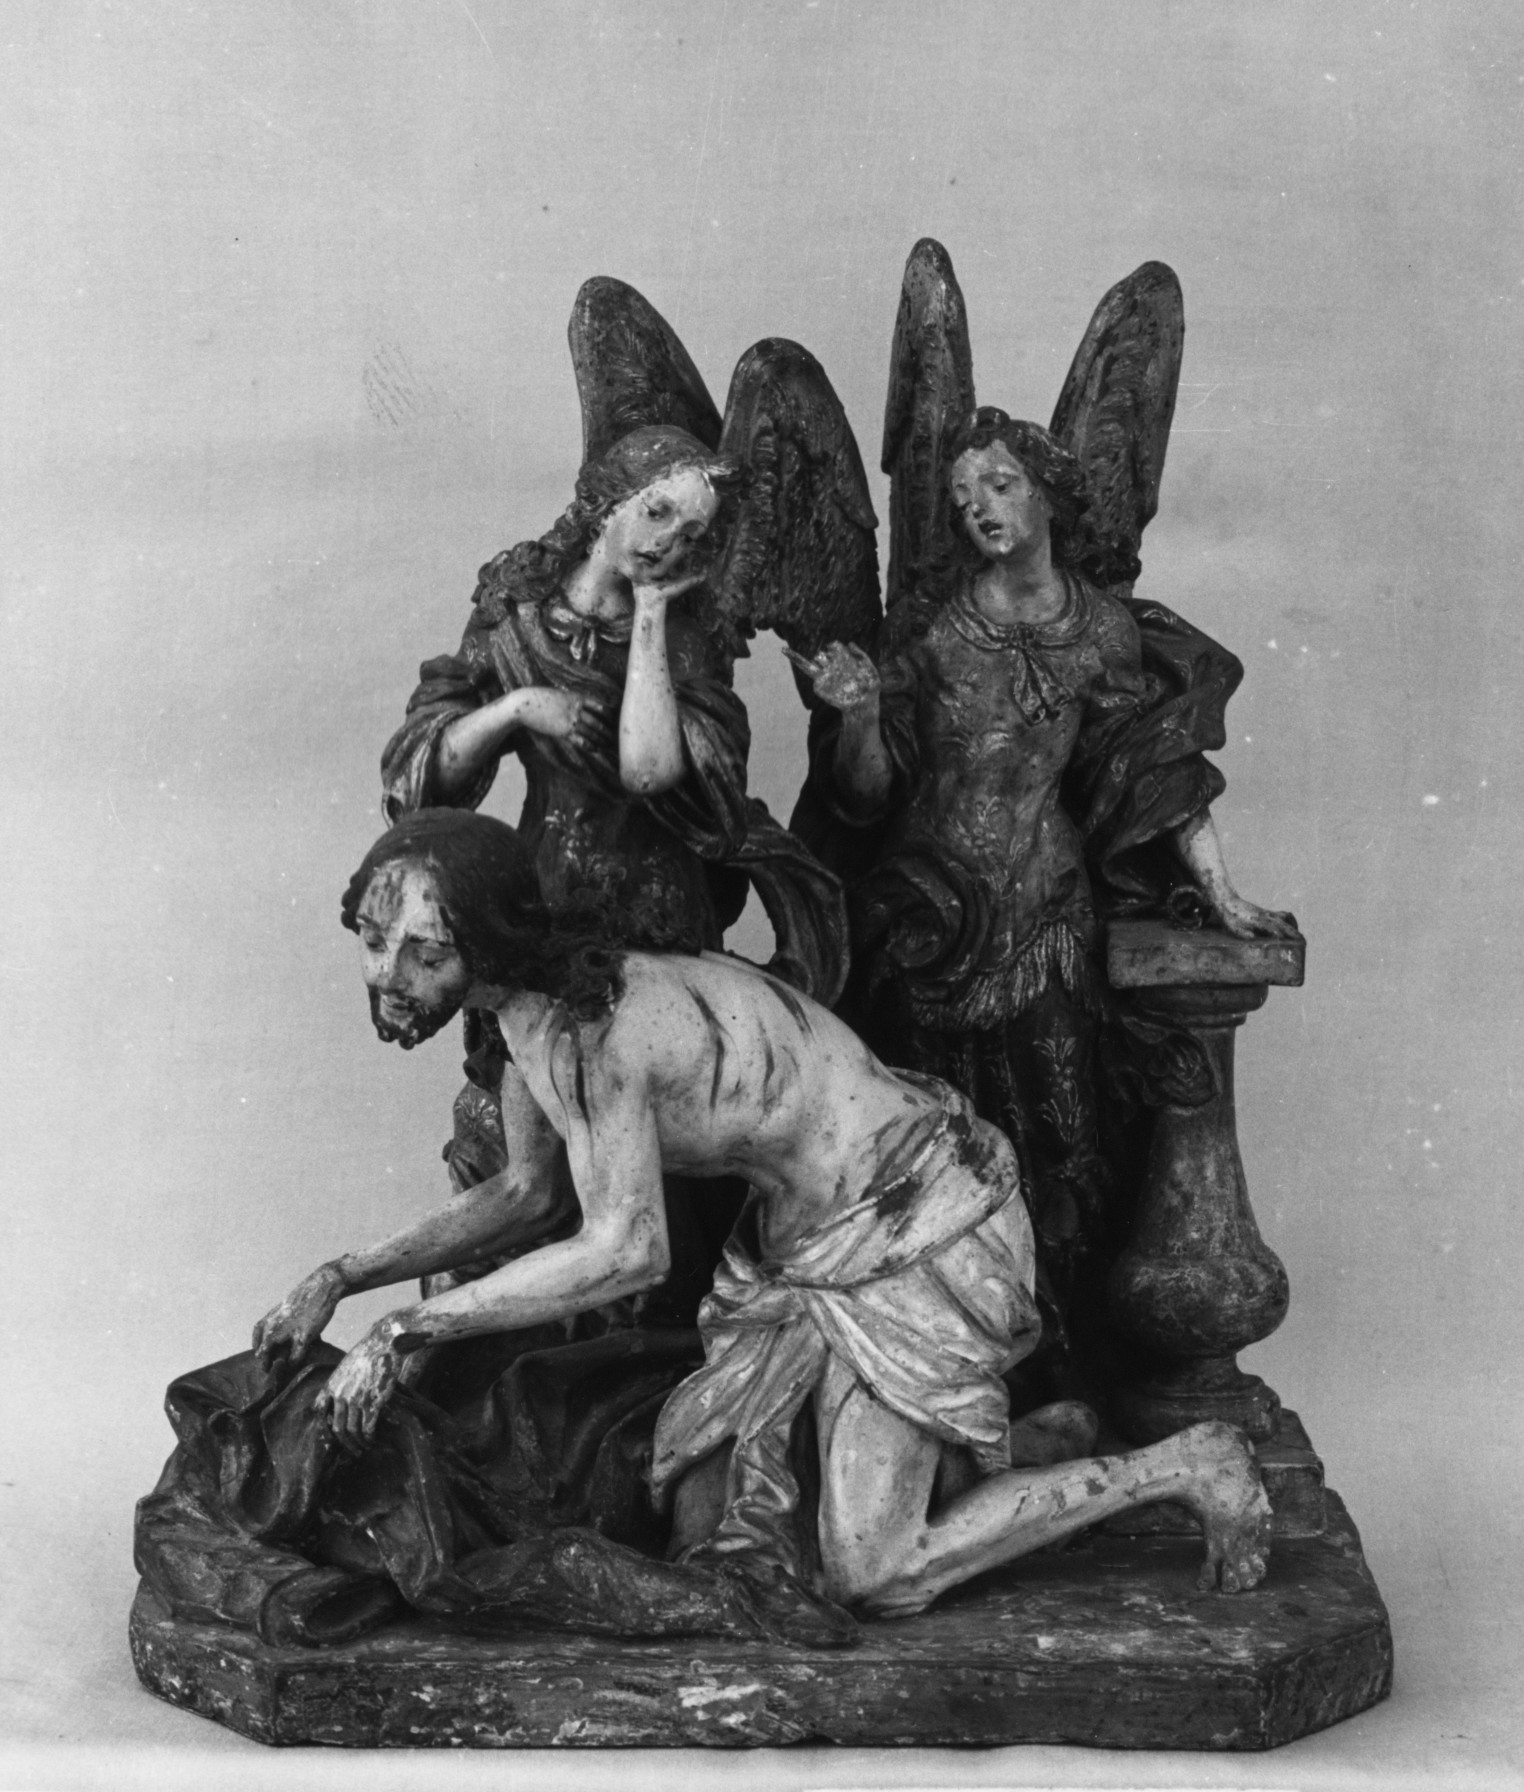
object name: statuette group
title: Angels mourning over Christ after the flagellation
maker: luisa roldán, called la roldana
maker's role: artist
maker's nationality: spanish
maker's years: 1652-1706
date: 1701-1733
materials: gilt, terracotta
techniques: polychrome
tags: sadness,angels,christ